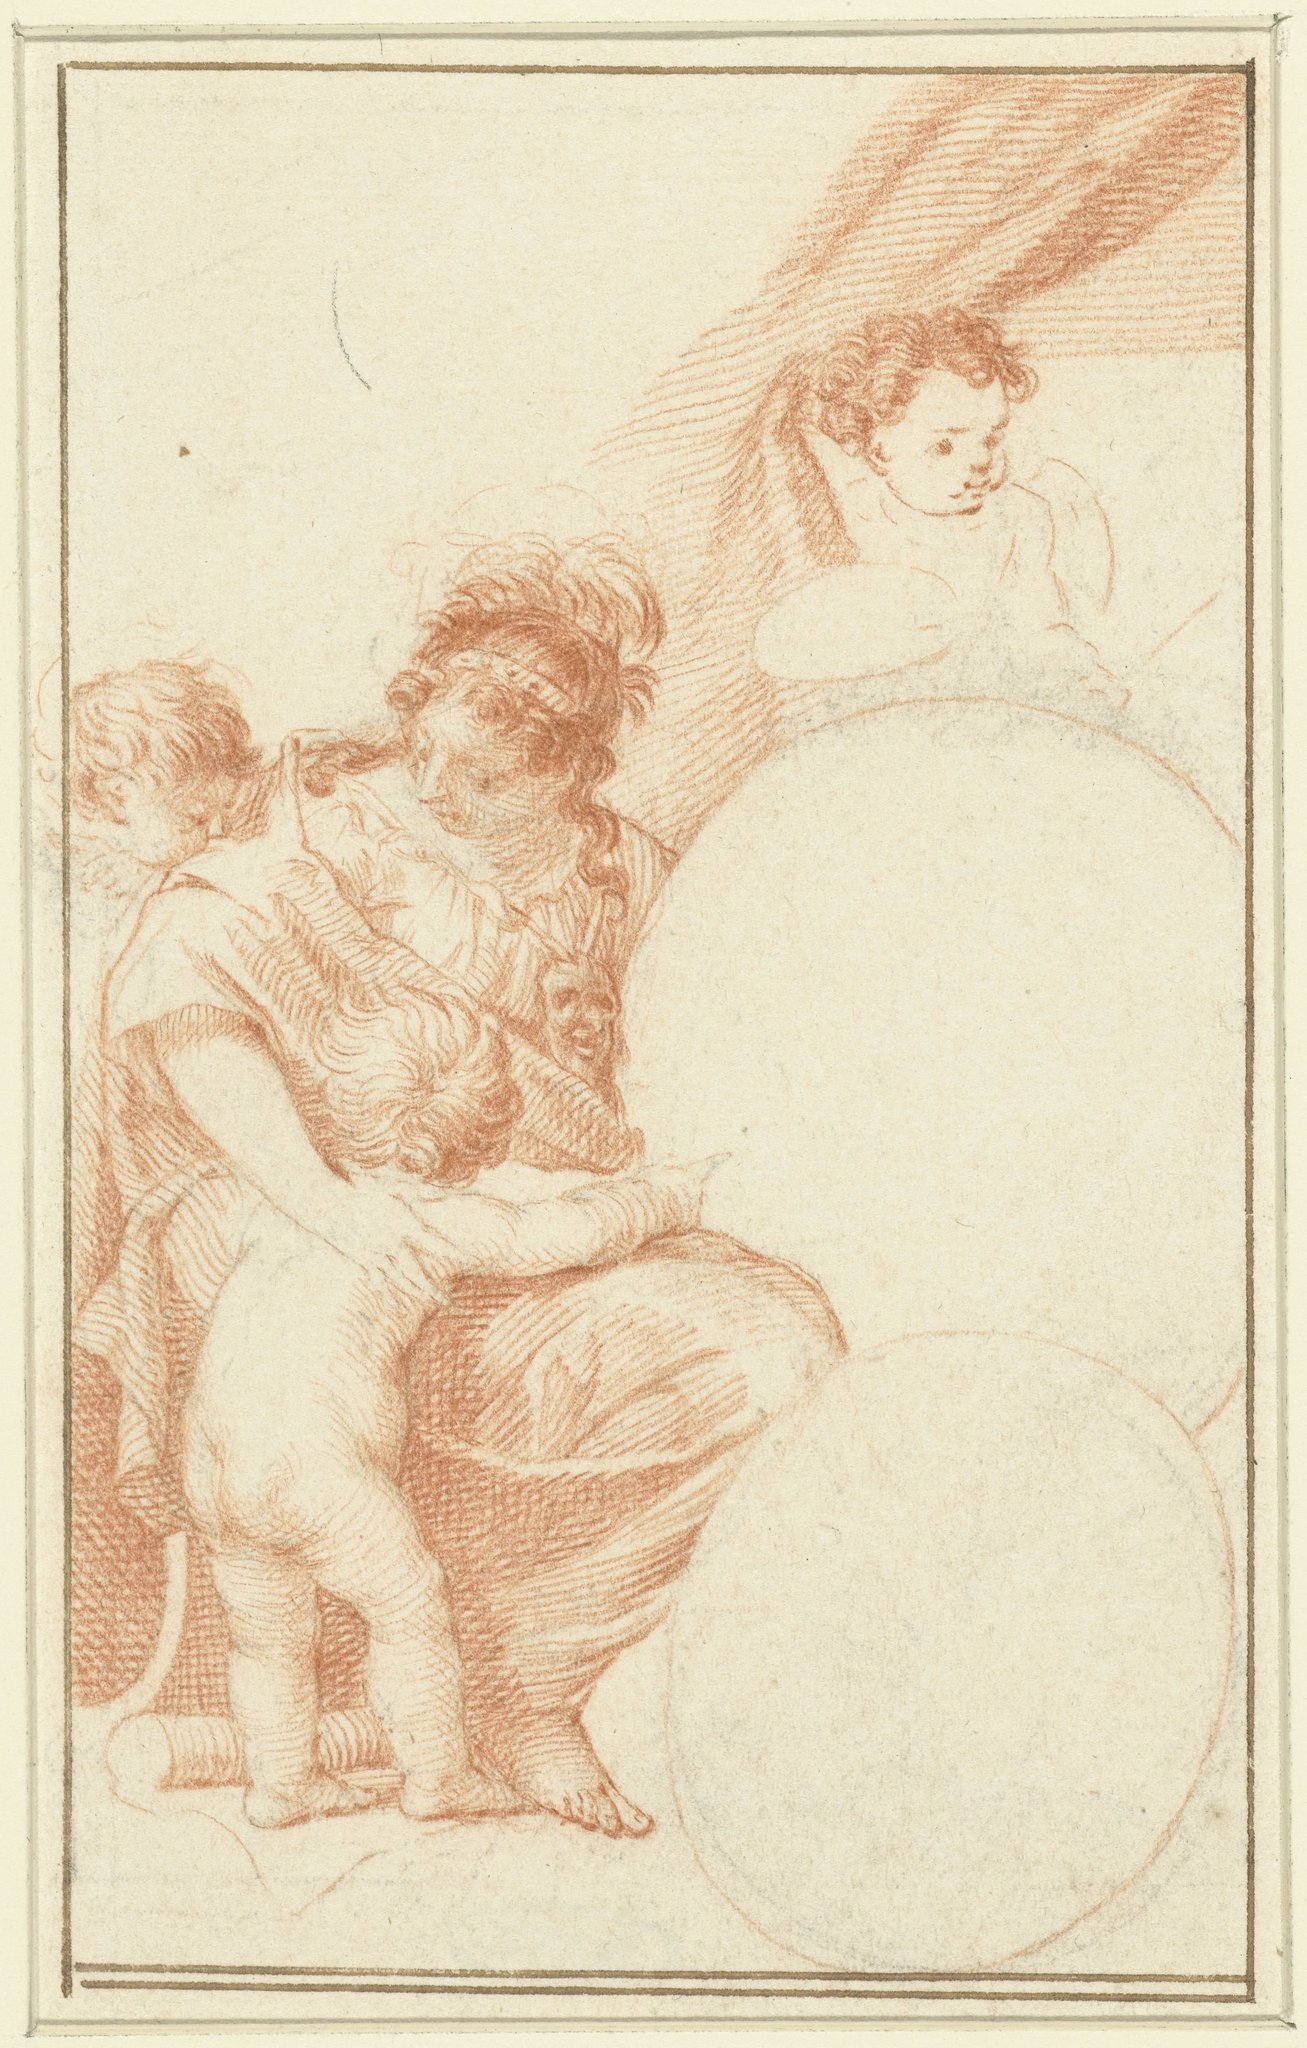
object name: drawing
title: Allegorisch randwerk voor twee ovale portretten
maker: jacob houbraken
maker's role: draughtsman, print maker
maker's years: 1698-1780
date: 1708-1780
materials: chalk, paper